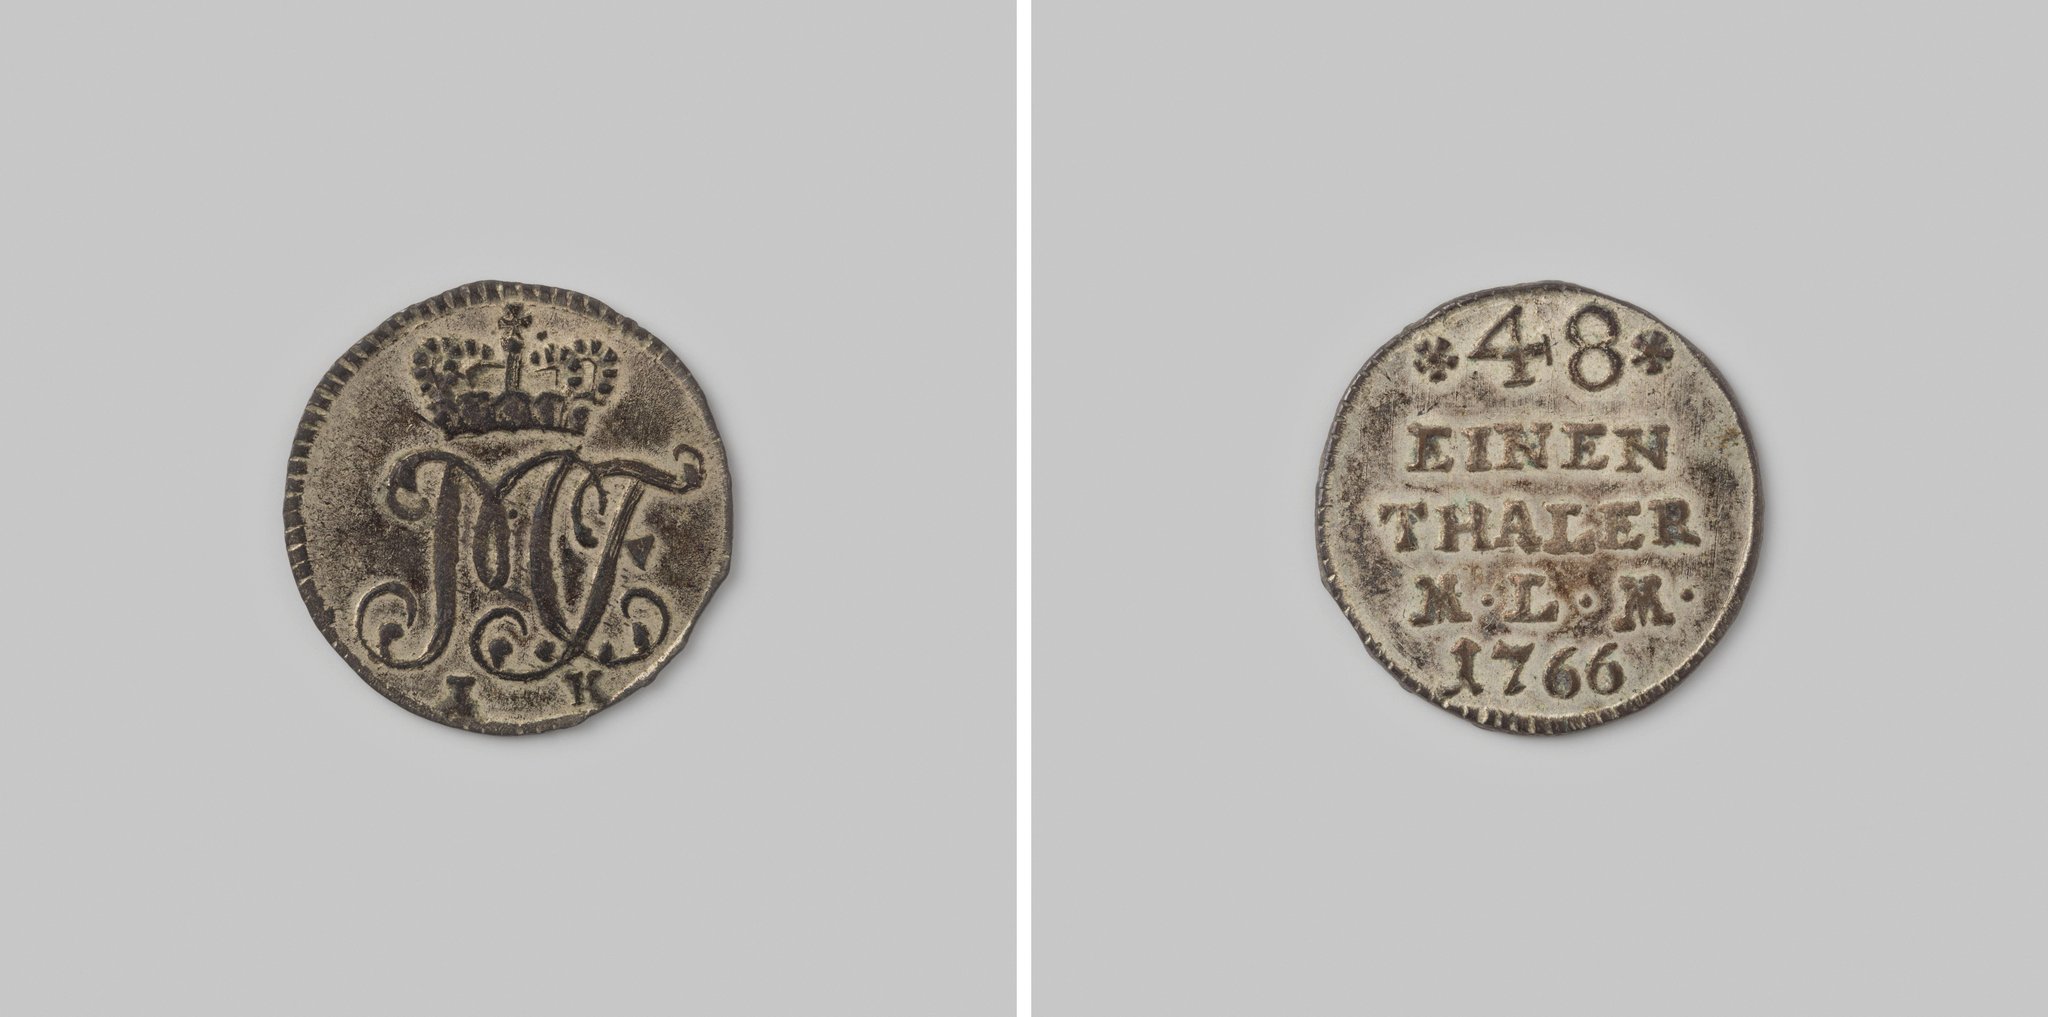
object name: coin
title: Bisdom Münster, Maximilian Friedrich, ½ groschen, 1766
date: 1766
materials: silver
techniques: striking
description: Zilveren munt. Voorzijde: gekroond monogram van de letters M en F. Keerzijde: waarde-aanduiding in drie regels. Jaartal onderaan. Gladde rand.